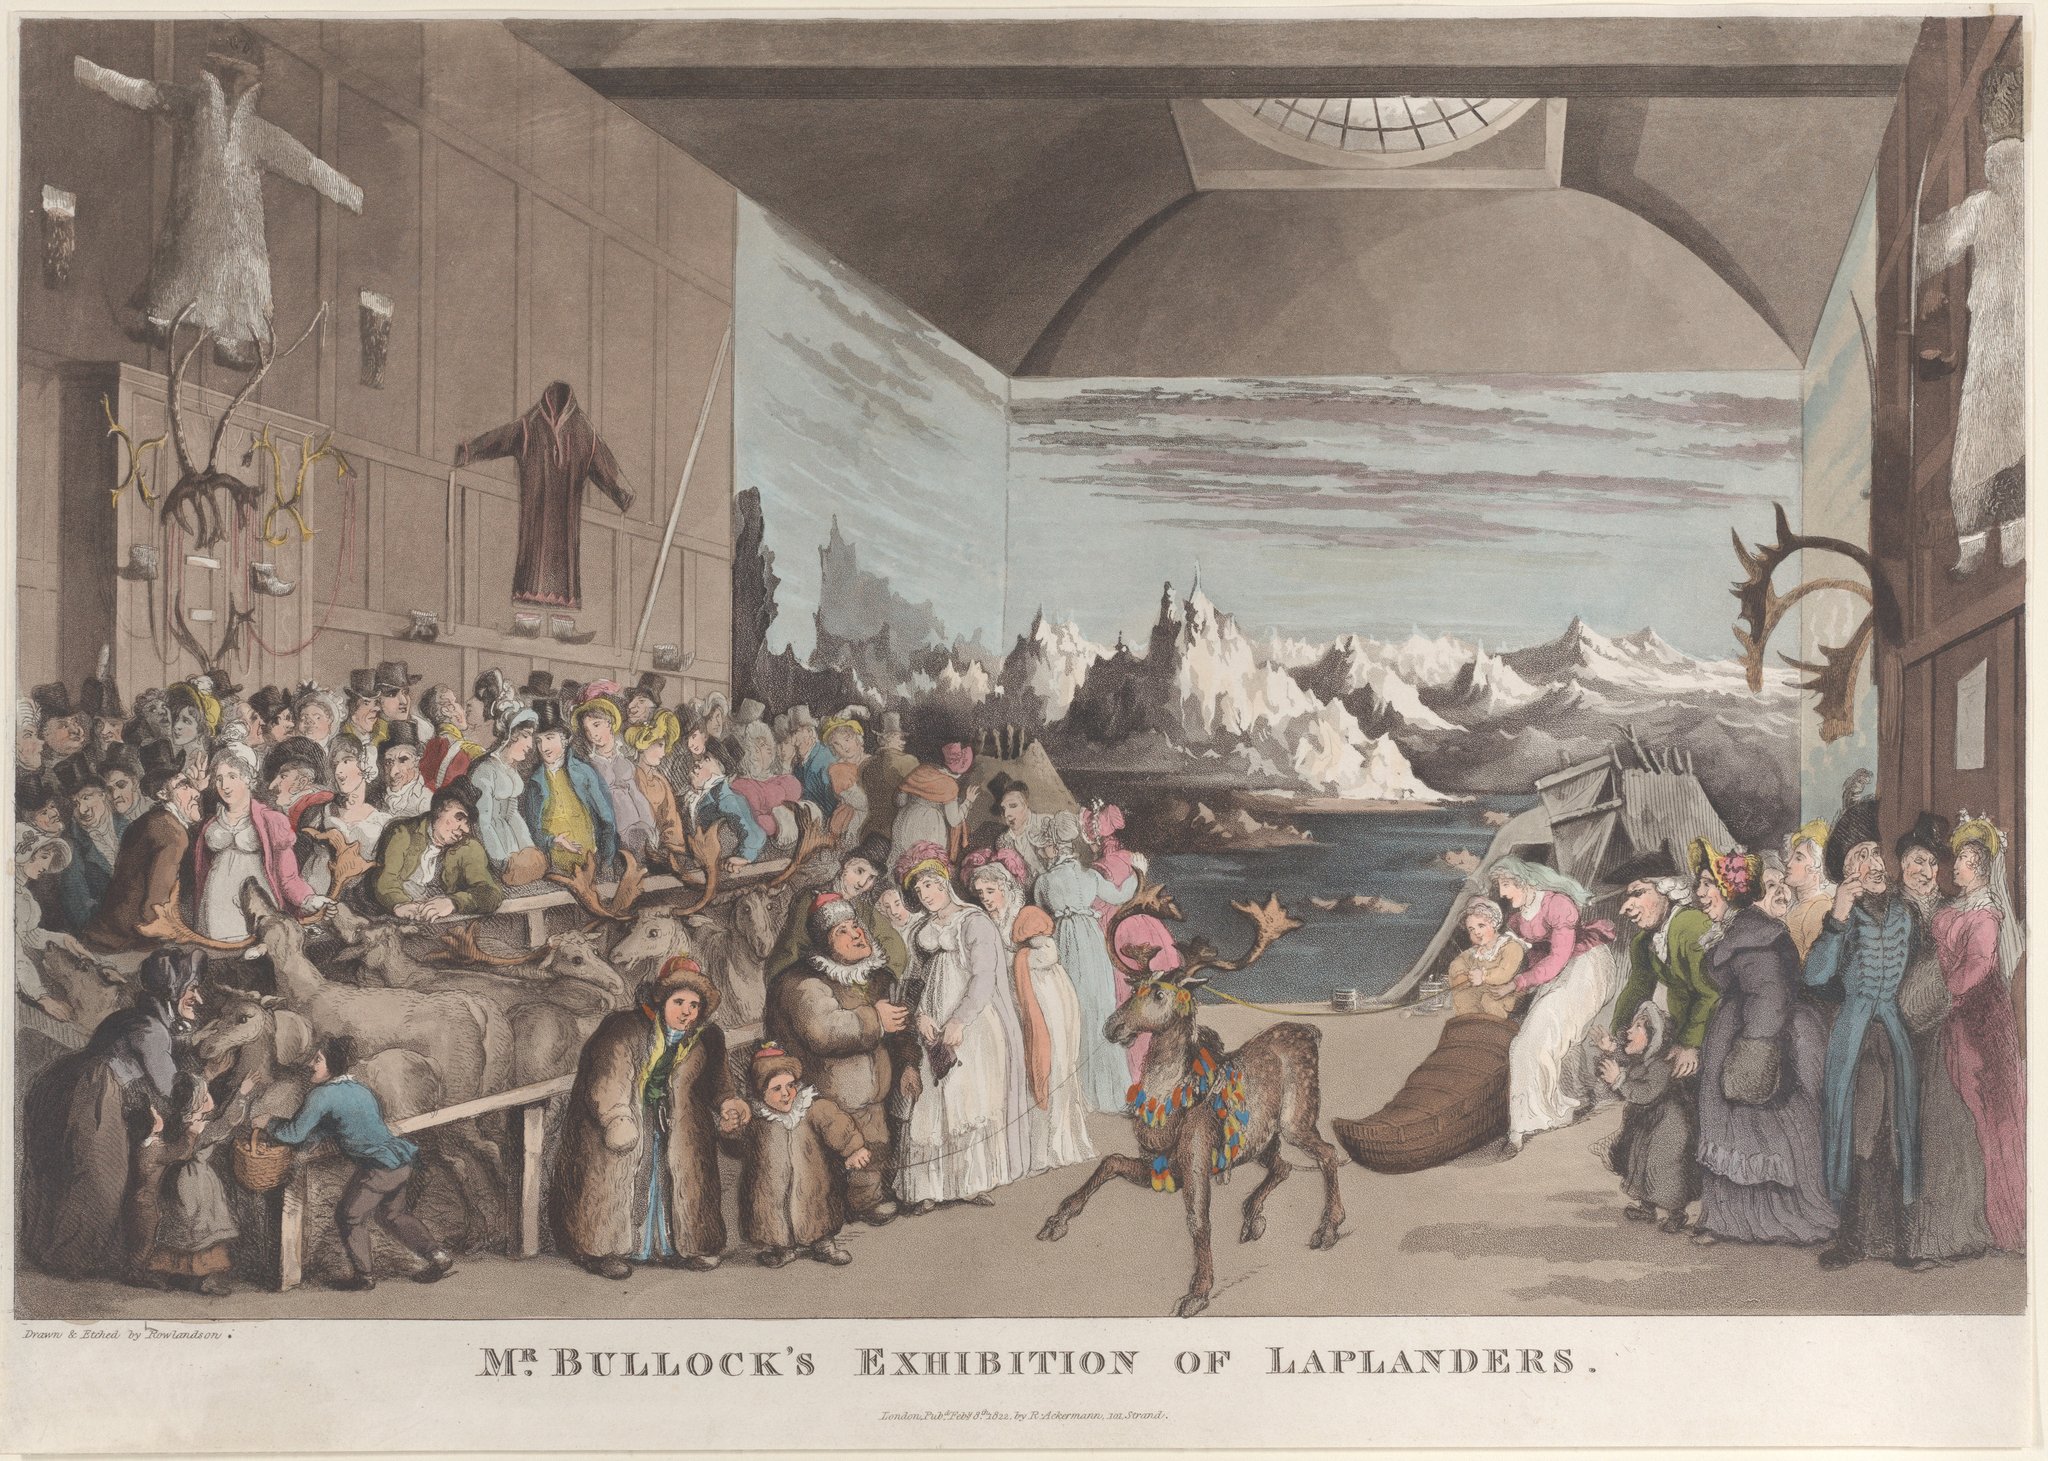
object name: print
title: Mr. Bullock's Exhibition of Laplanders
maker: thomas rowlandson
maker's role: artist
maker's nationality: british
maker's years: 1757-1827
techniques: aquatint, etching, hand coloring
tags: animals,men,women,spectators